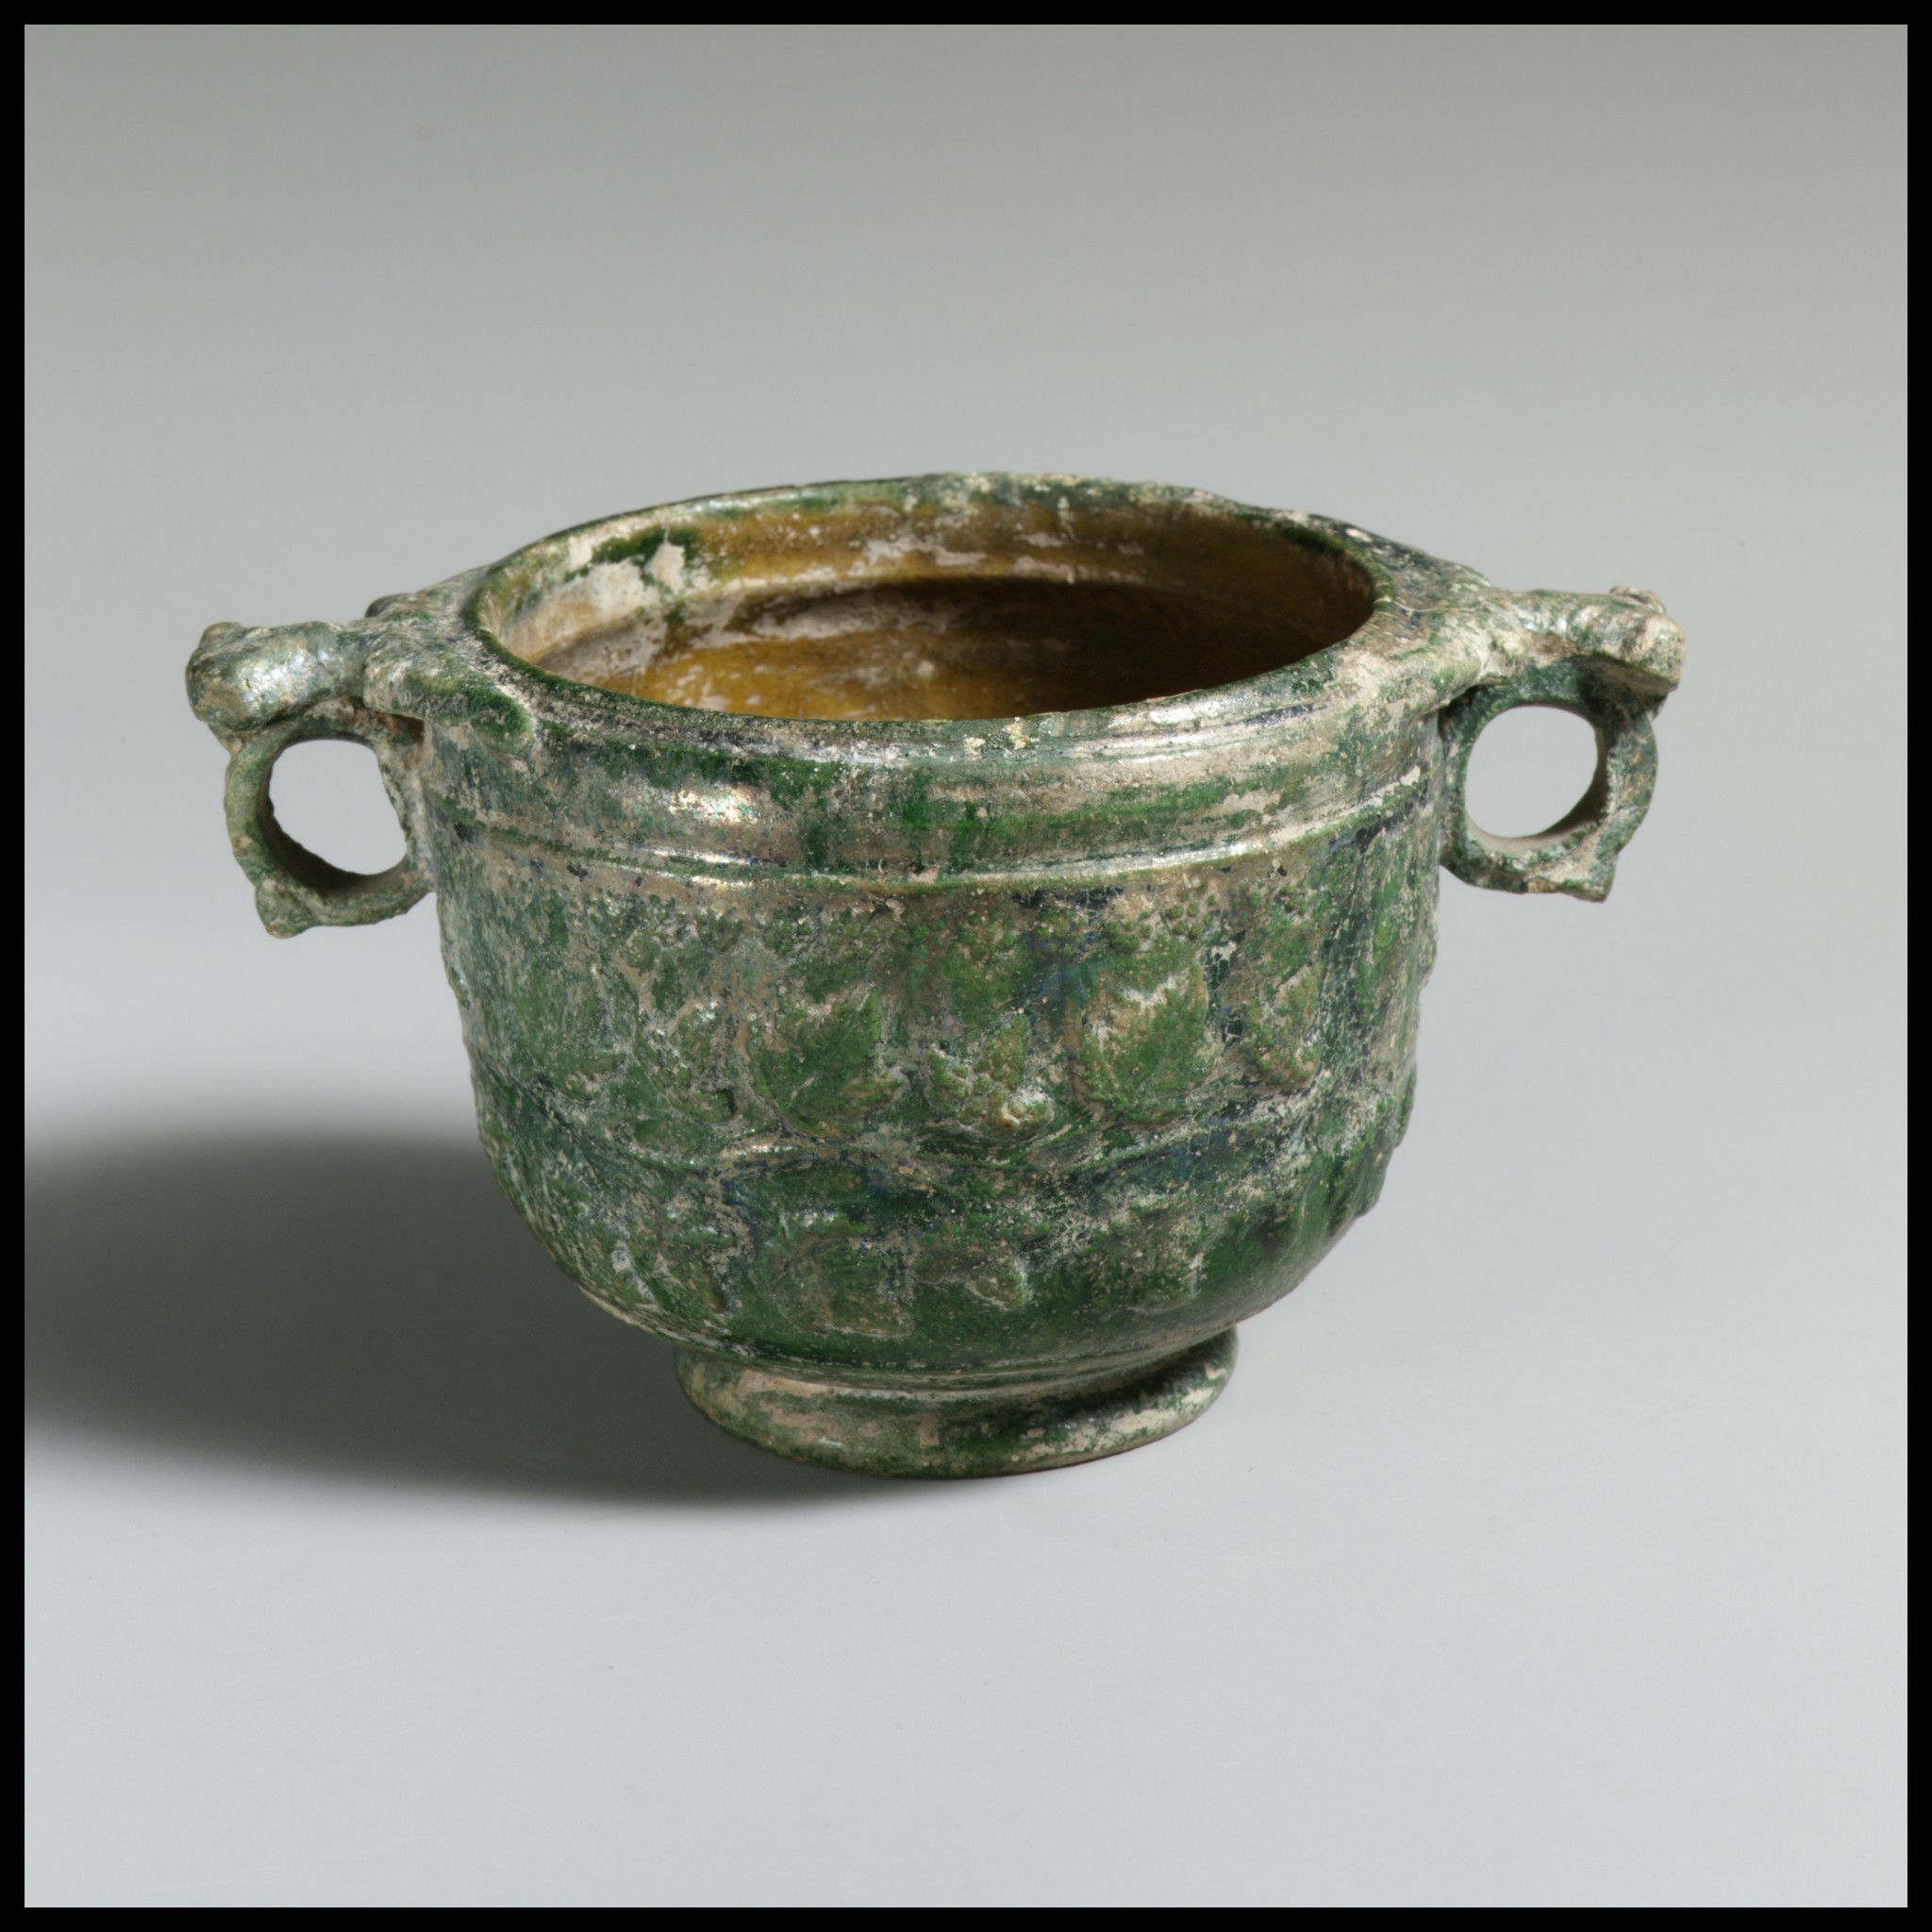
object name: skyphos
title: Terracotta scyphus (drinking cup)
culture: roman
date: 1-50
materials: terracotta